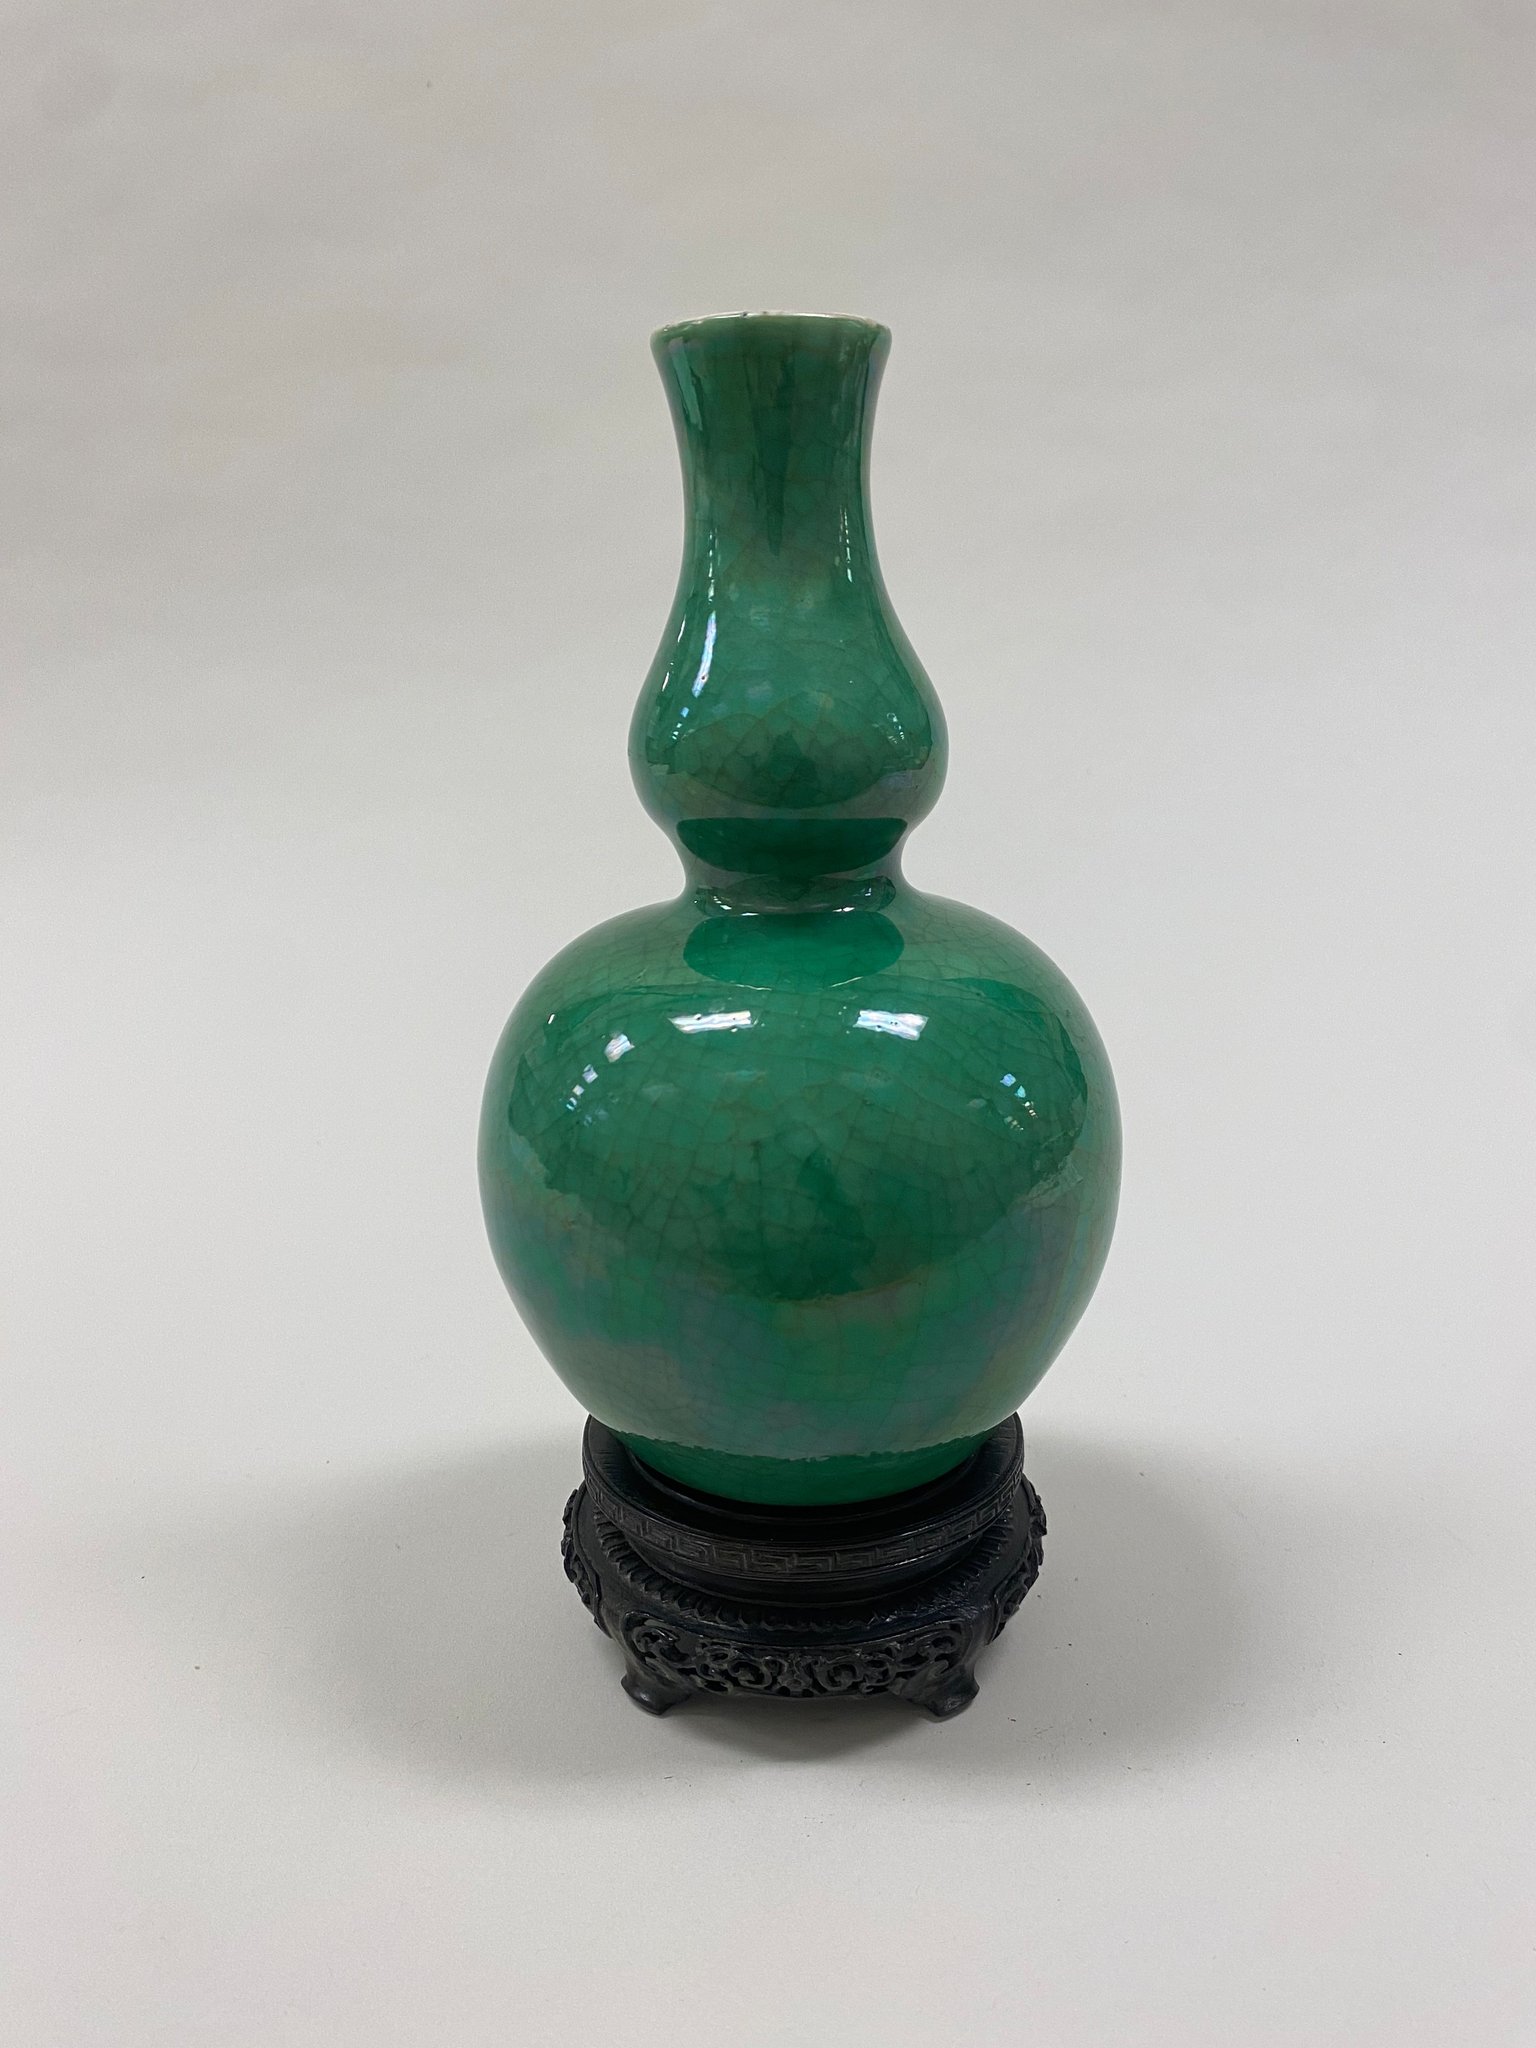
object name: vase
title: Double-gourd vase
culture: chinese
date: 1701-1733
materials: glaze, porcelain